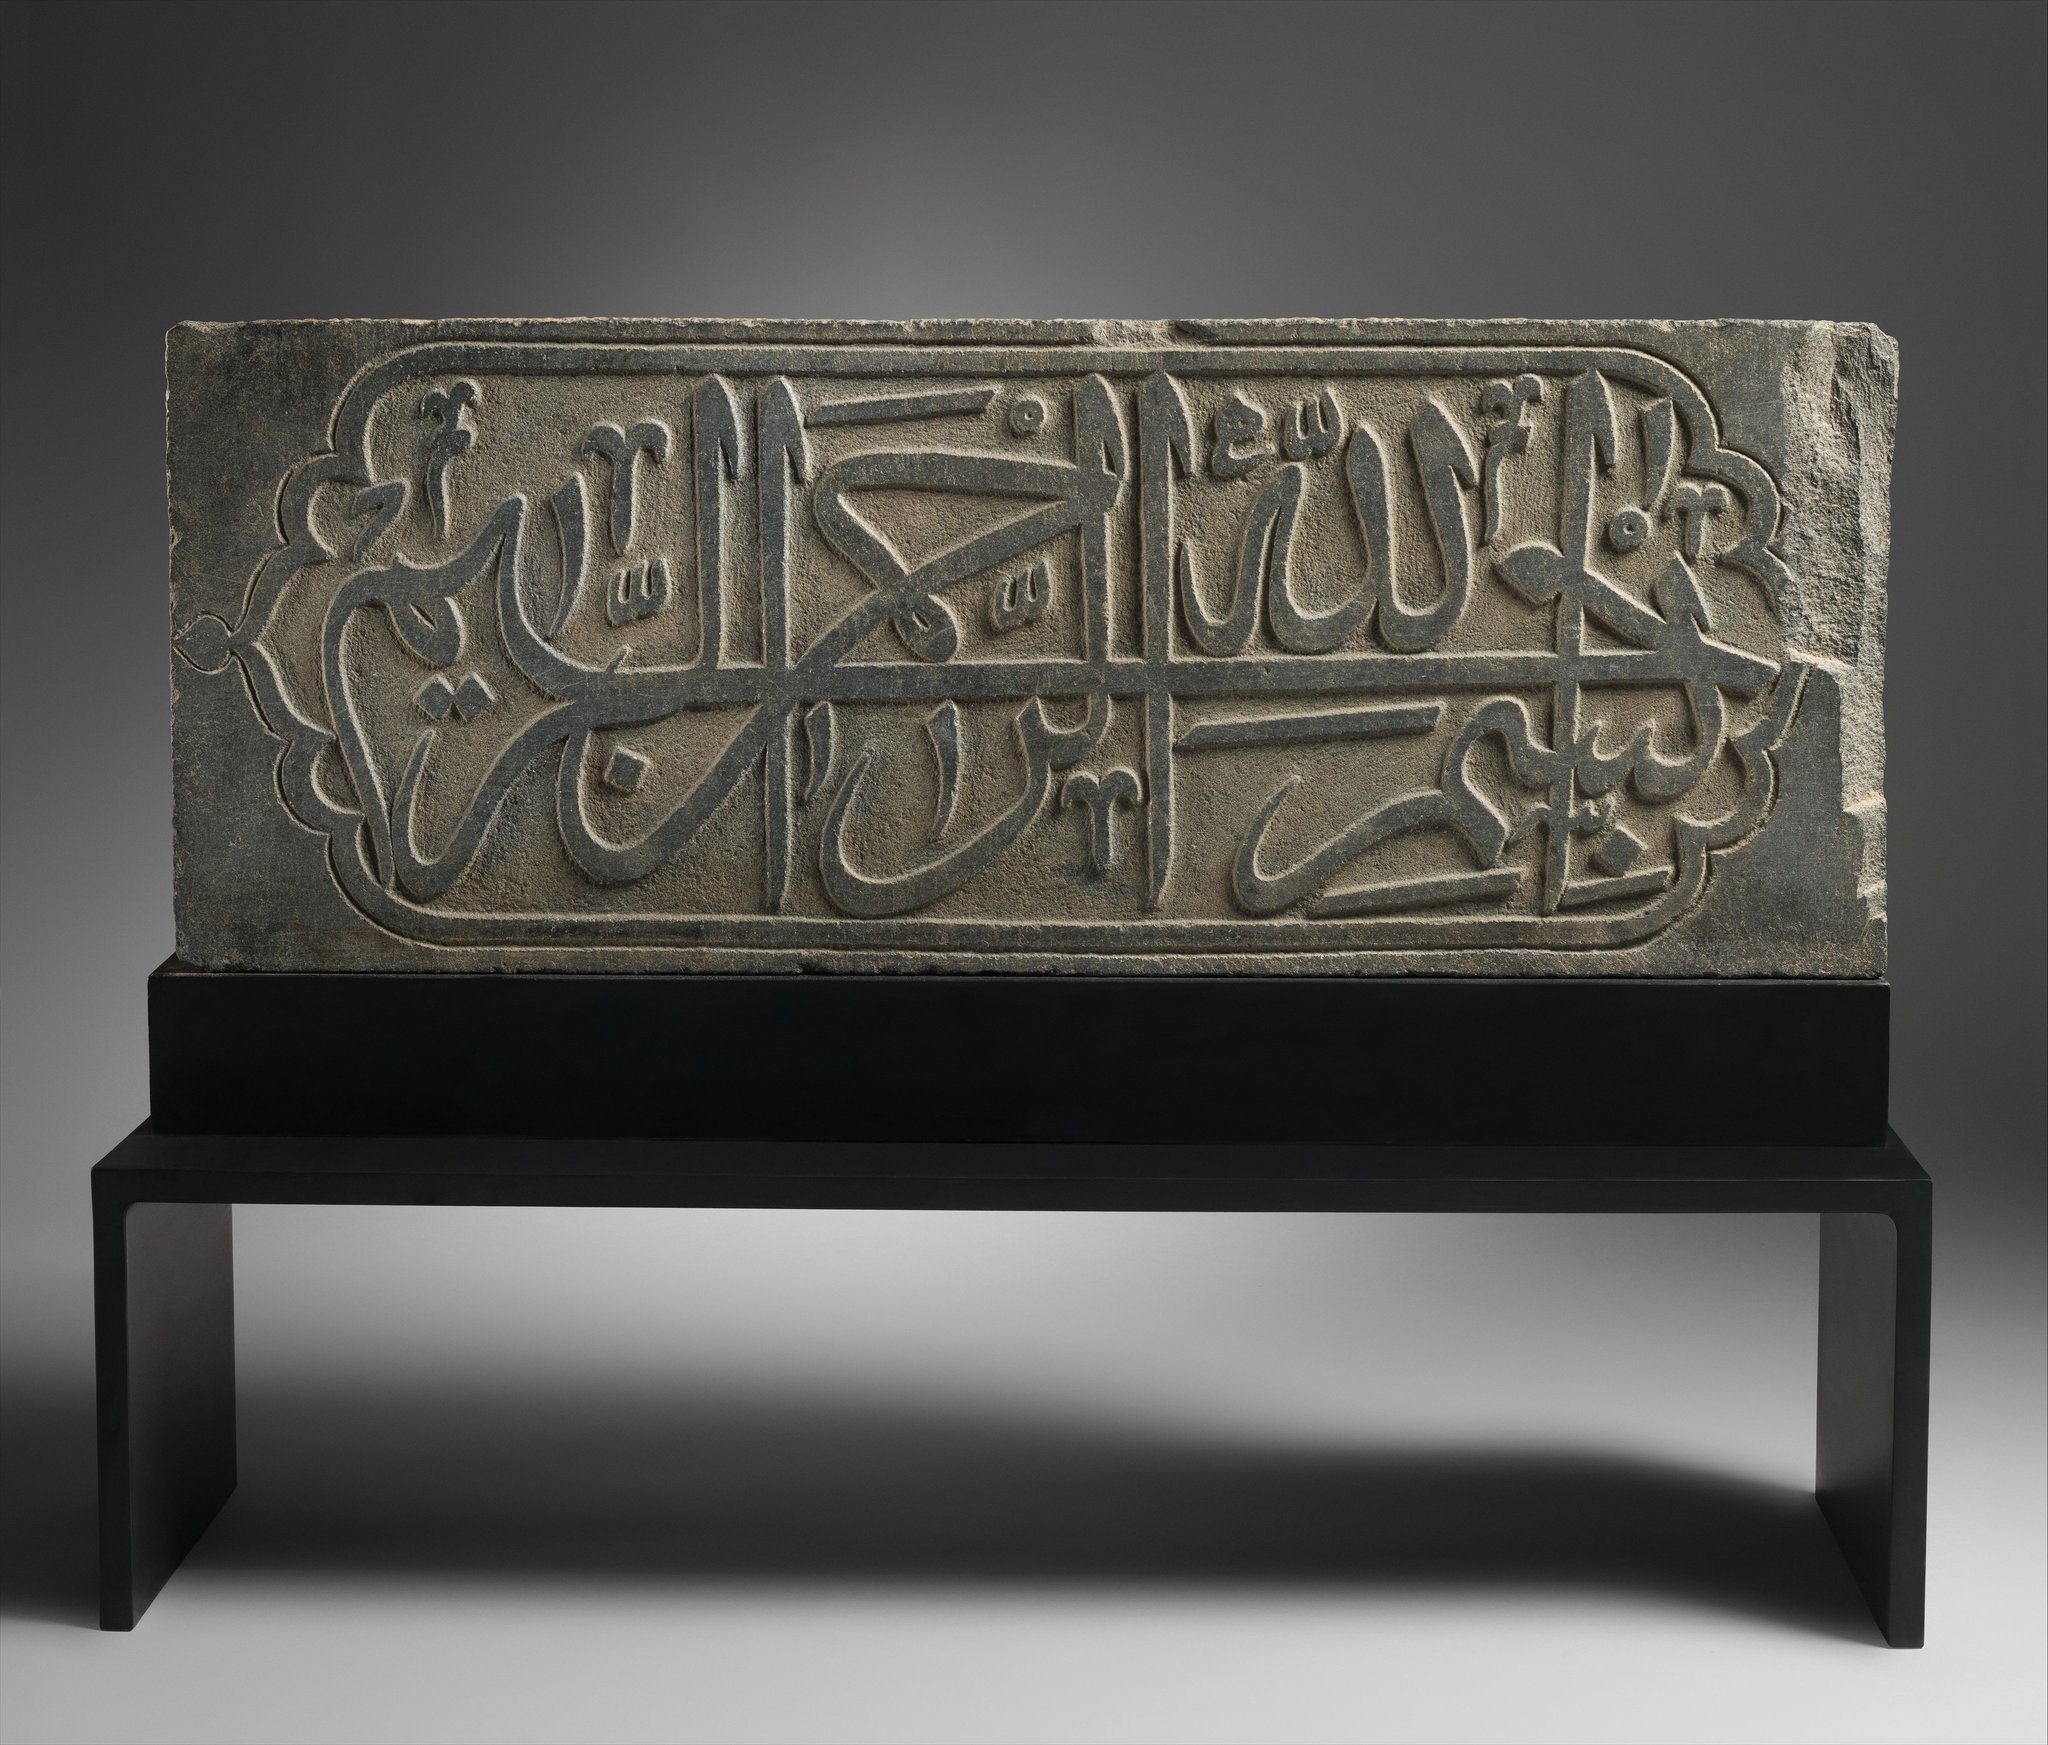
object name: panel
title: Inscribed Panel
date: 1634-1666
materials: stone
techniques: carving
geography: golconda